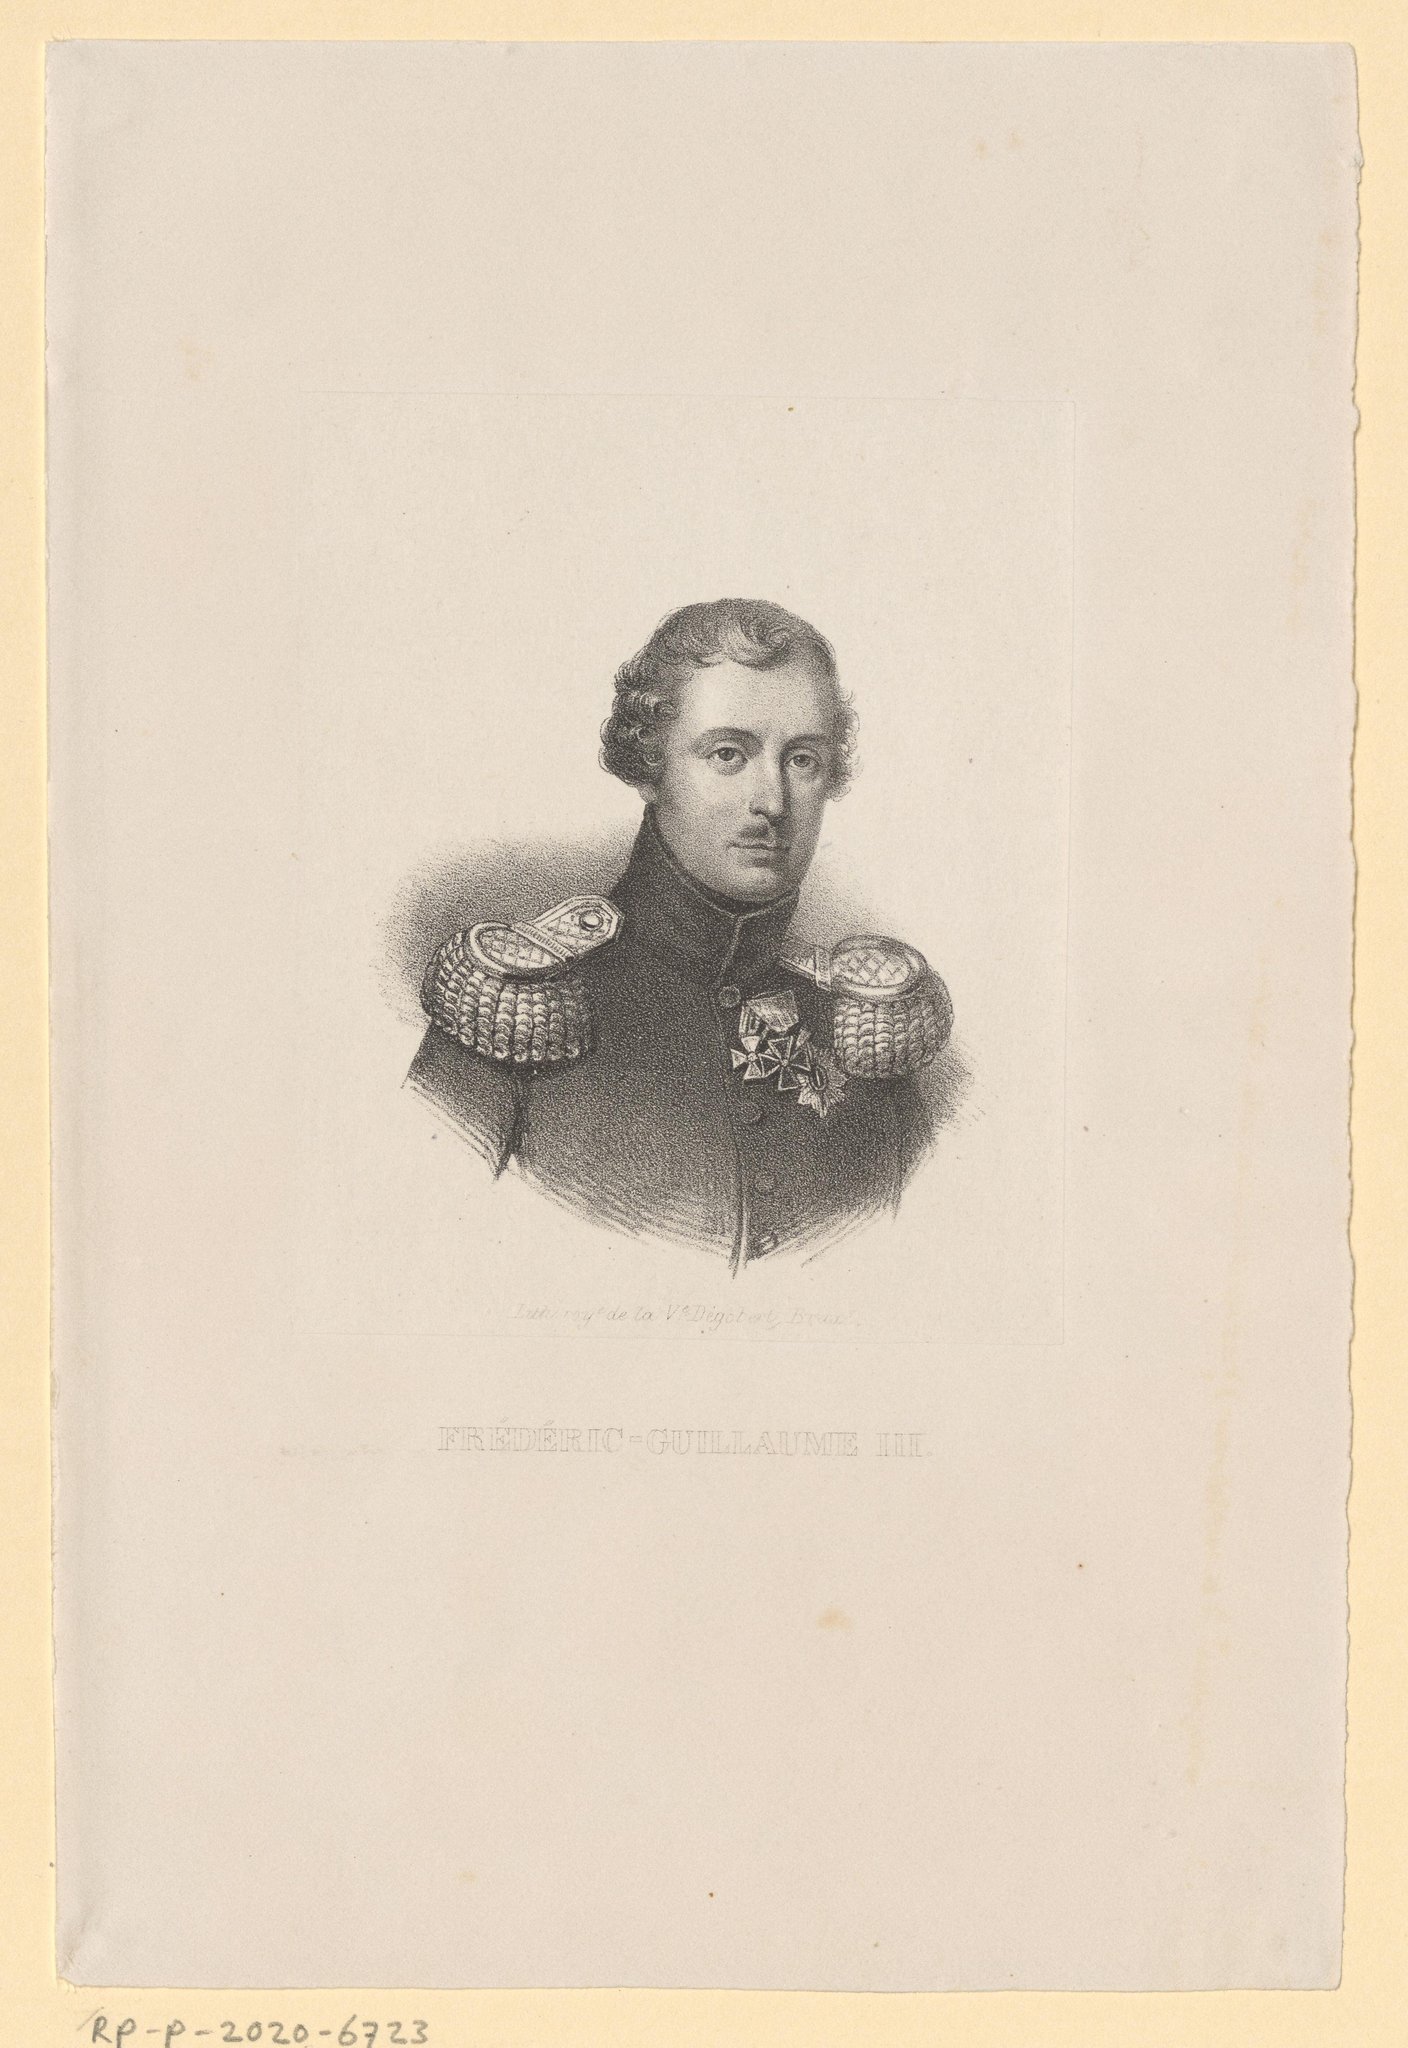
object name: print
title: Portret van Frederik Willem III van Pruisen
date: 1844-1849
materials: paper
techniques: lithograph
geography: brussels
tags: berlin, frederik willem iii koning van pruisen, historical persons, (military) uniforms, king